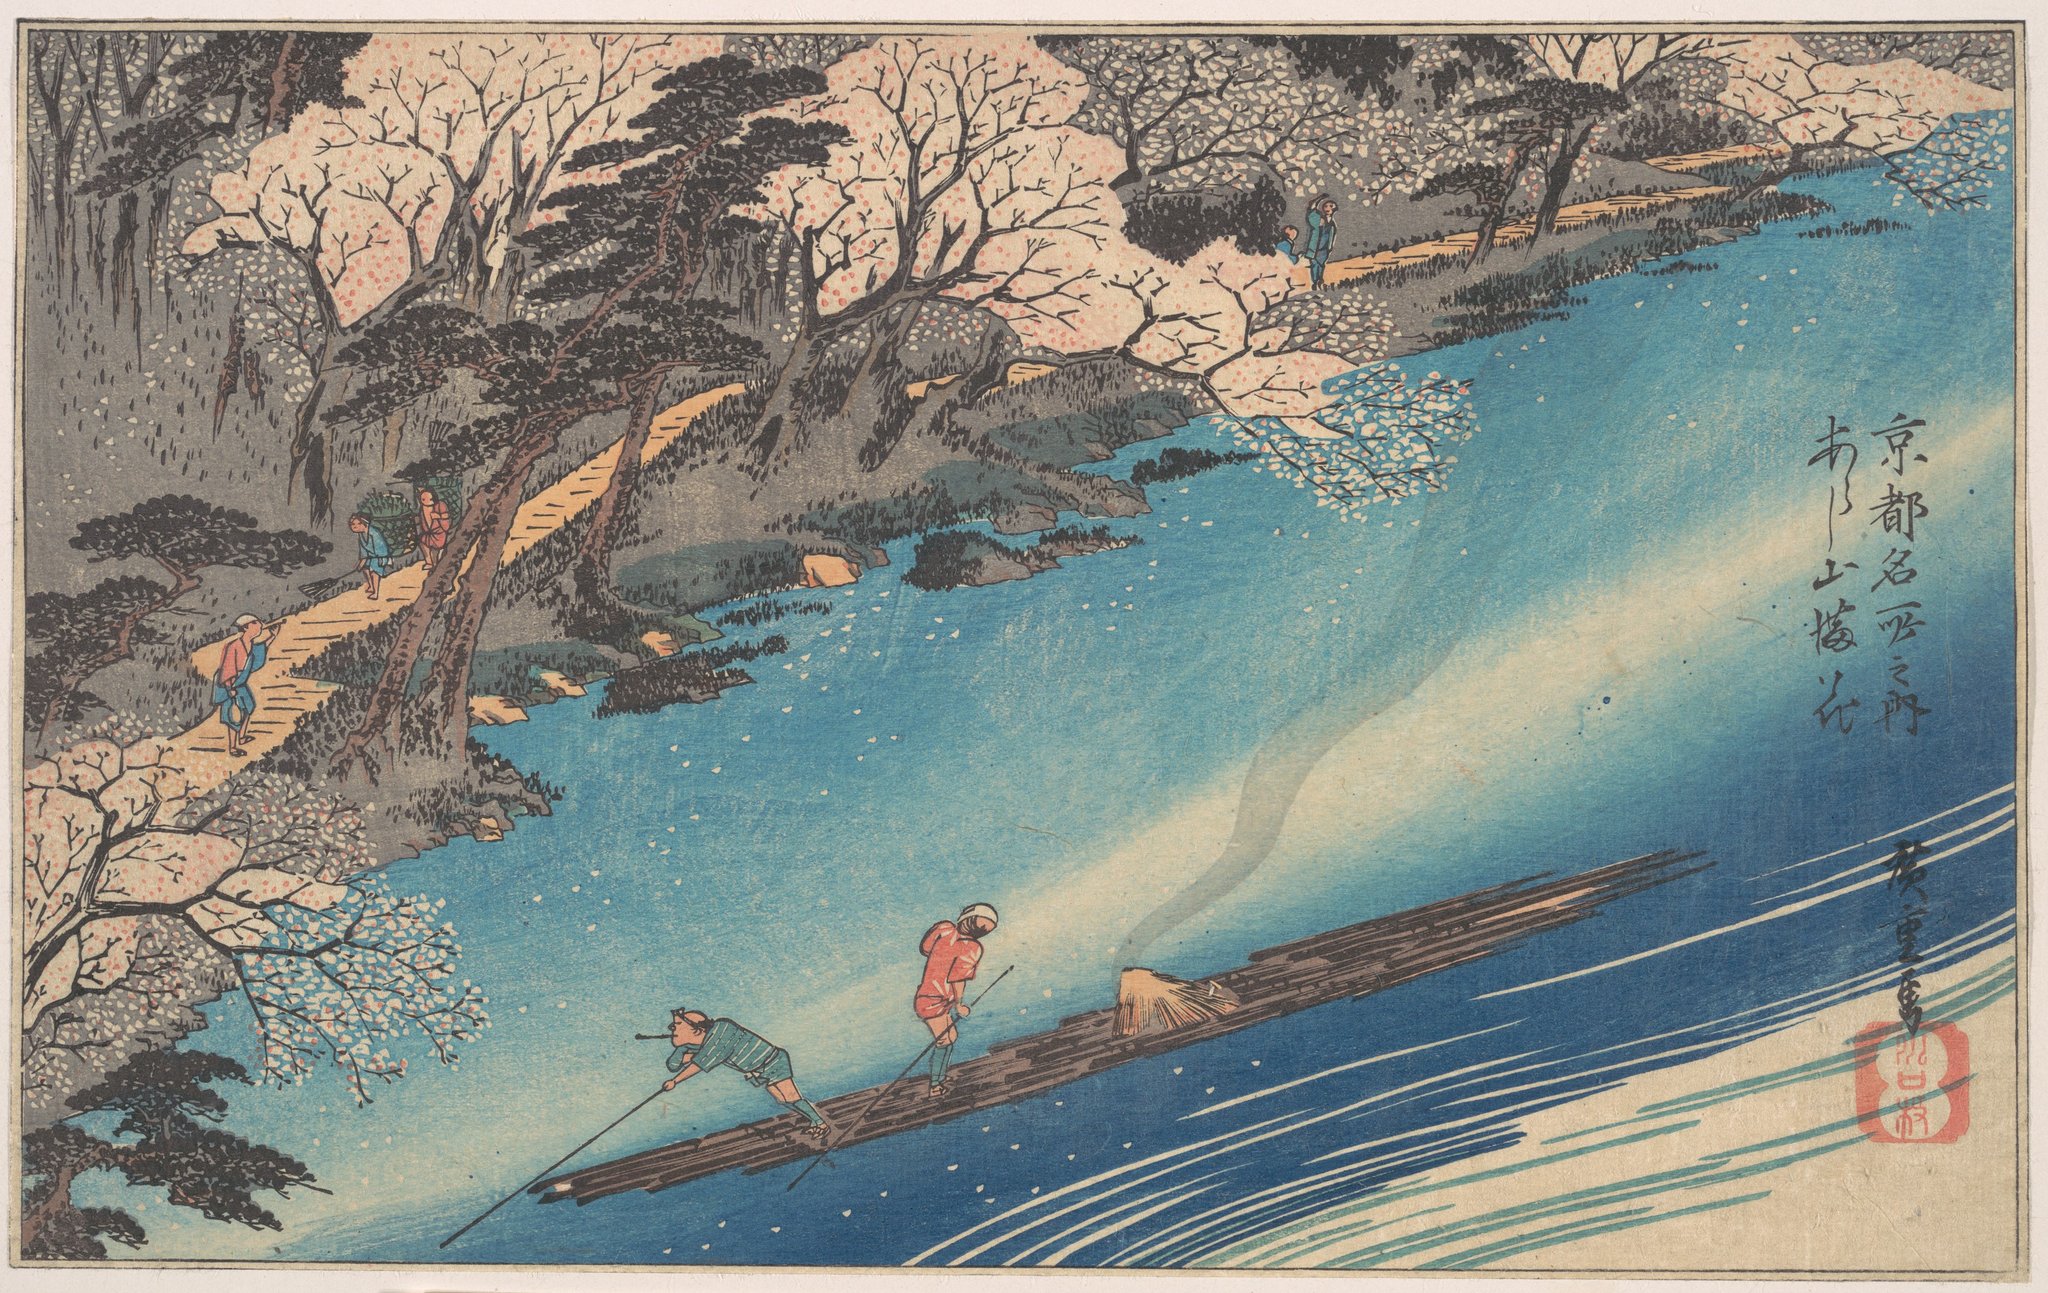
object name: print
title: Arashiyama Manka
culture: japanese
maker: utagawa hiroshige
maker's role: artist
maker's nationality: japanese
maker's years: 1797-1858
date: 1797-1858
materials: ink, paper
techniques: woodblock print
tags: rivers,trees,boats